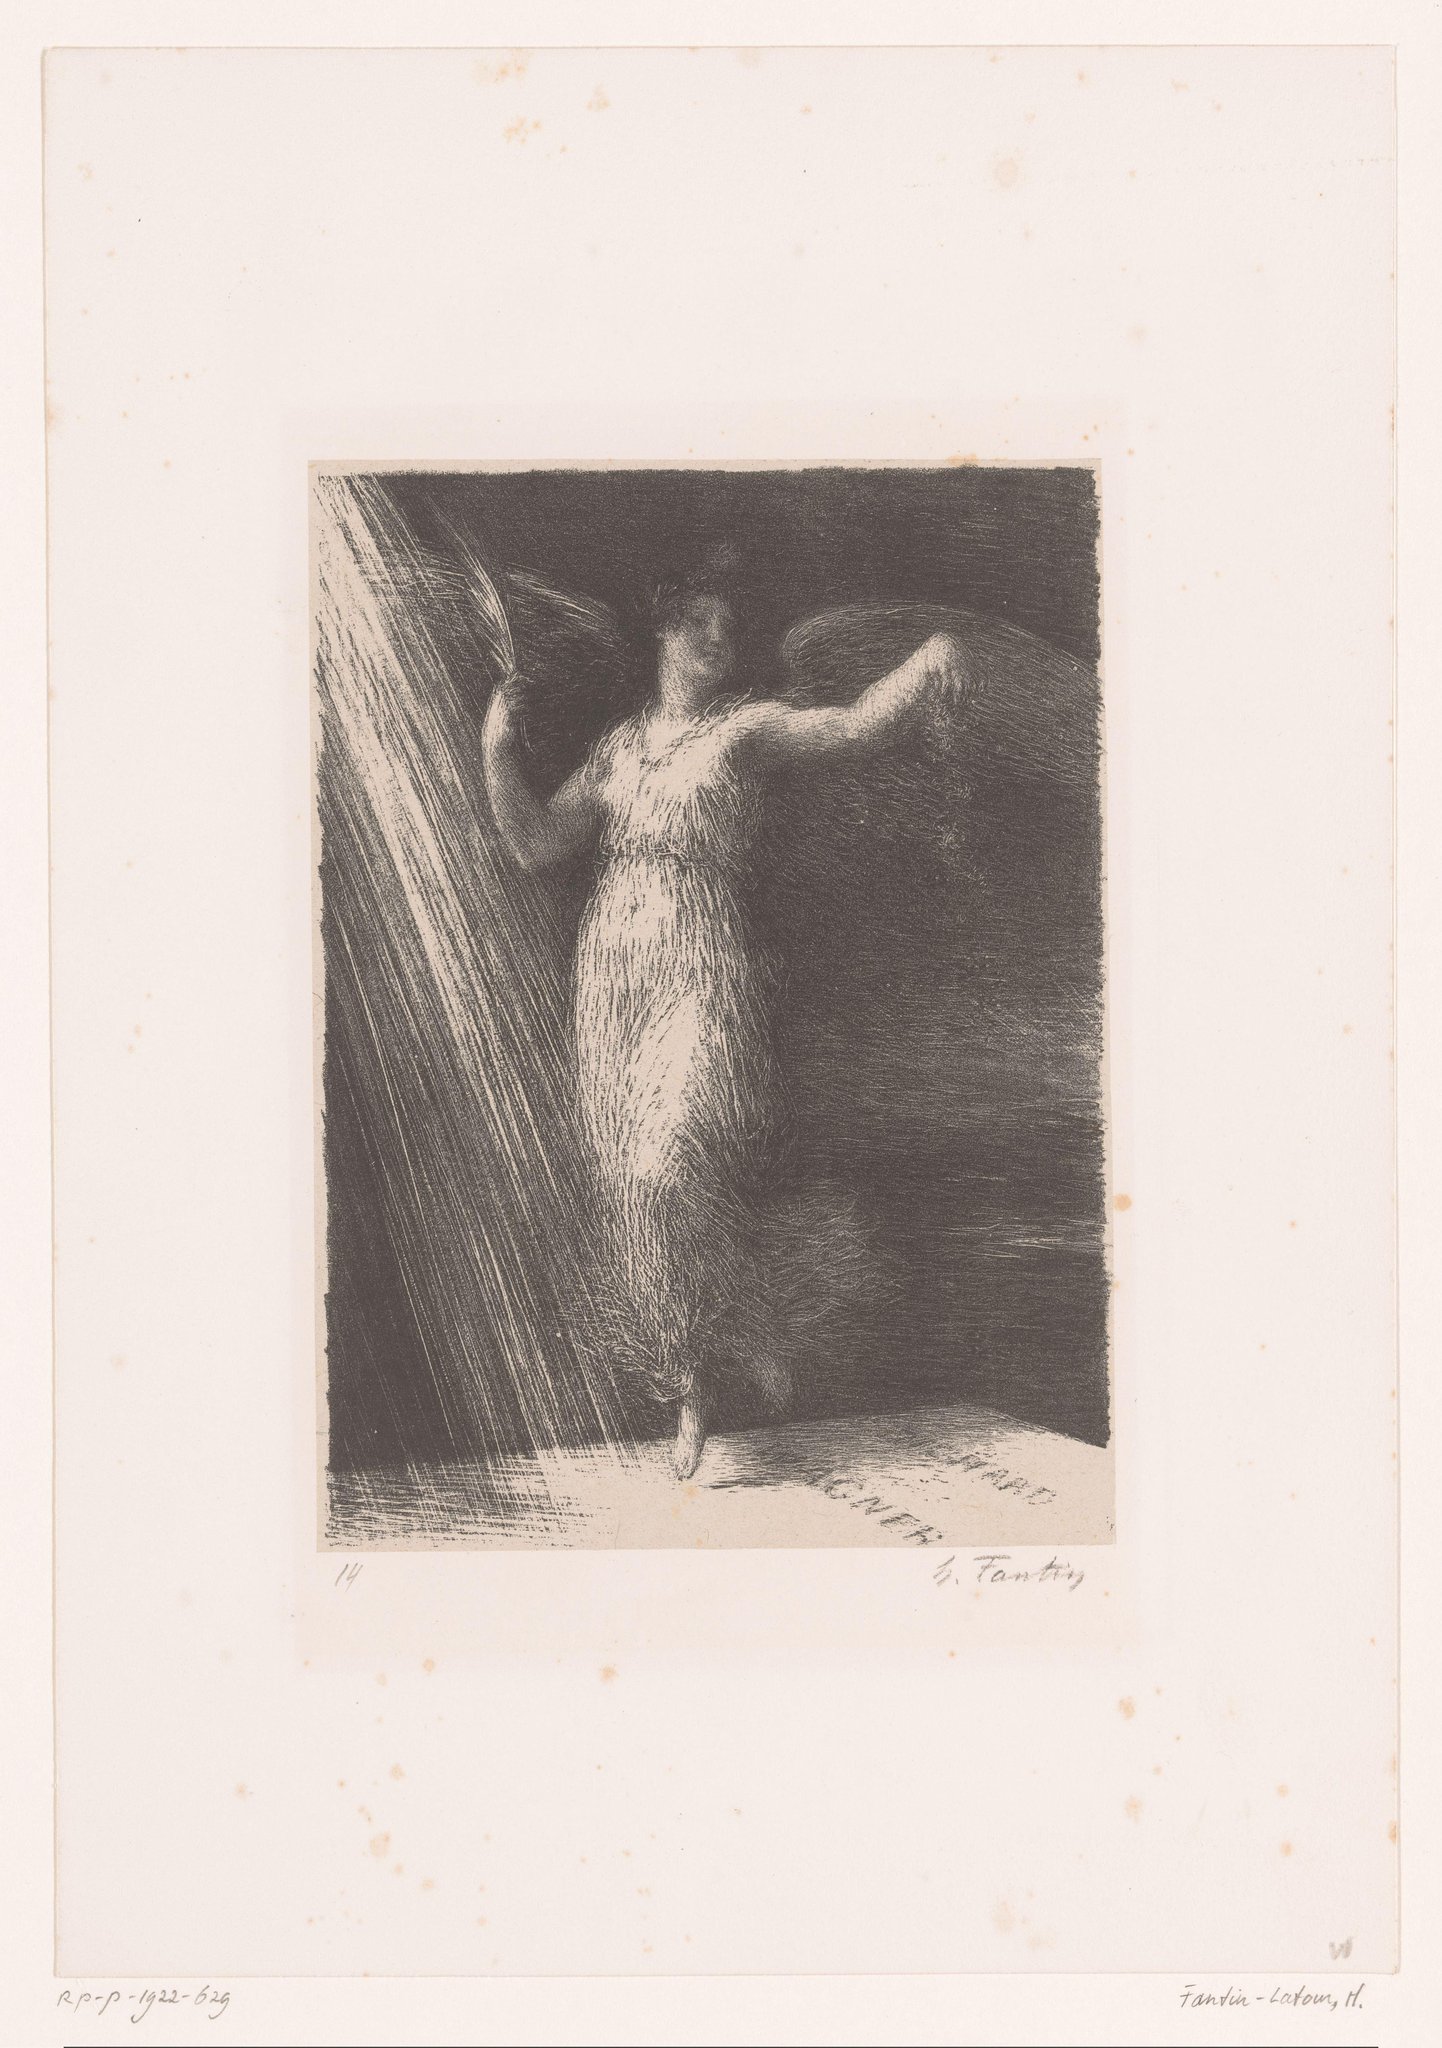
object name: print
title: Glorie strooit bloemen op het graf van Wagner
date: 1886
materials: paper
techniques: lithography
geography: paris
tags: fame; 'fama', 'fama buona', 'fama chiara' (ripa) (+ personification), fama as roman personification, gravestone, tombstone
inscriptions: collector's mark: Lugt 2228a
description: Prent gebruikt voor: A. Jullien, Richard Wagner: sa vie et ses œuvres, Parijs 1886.